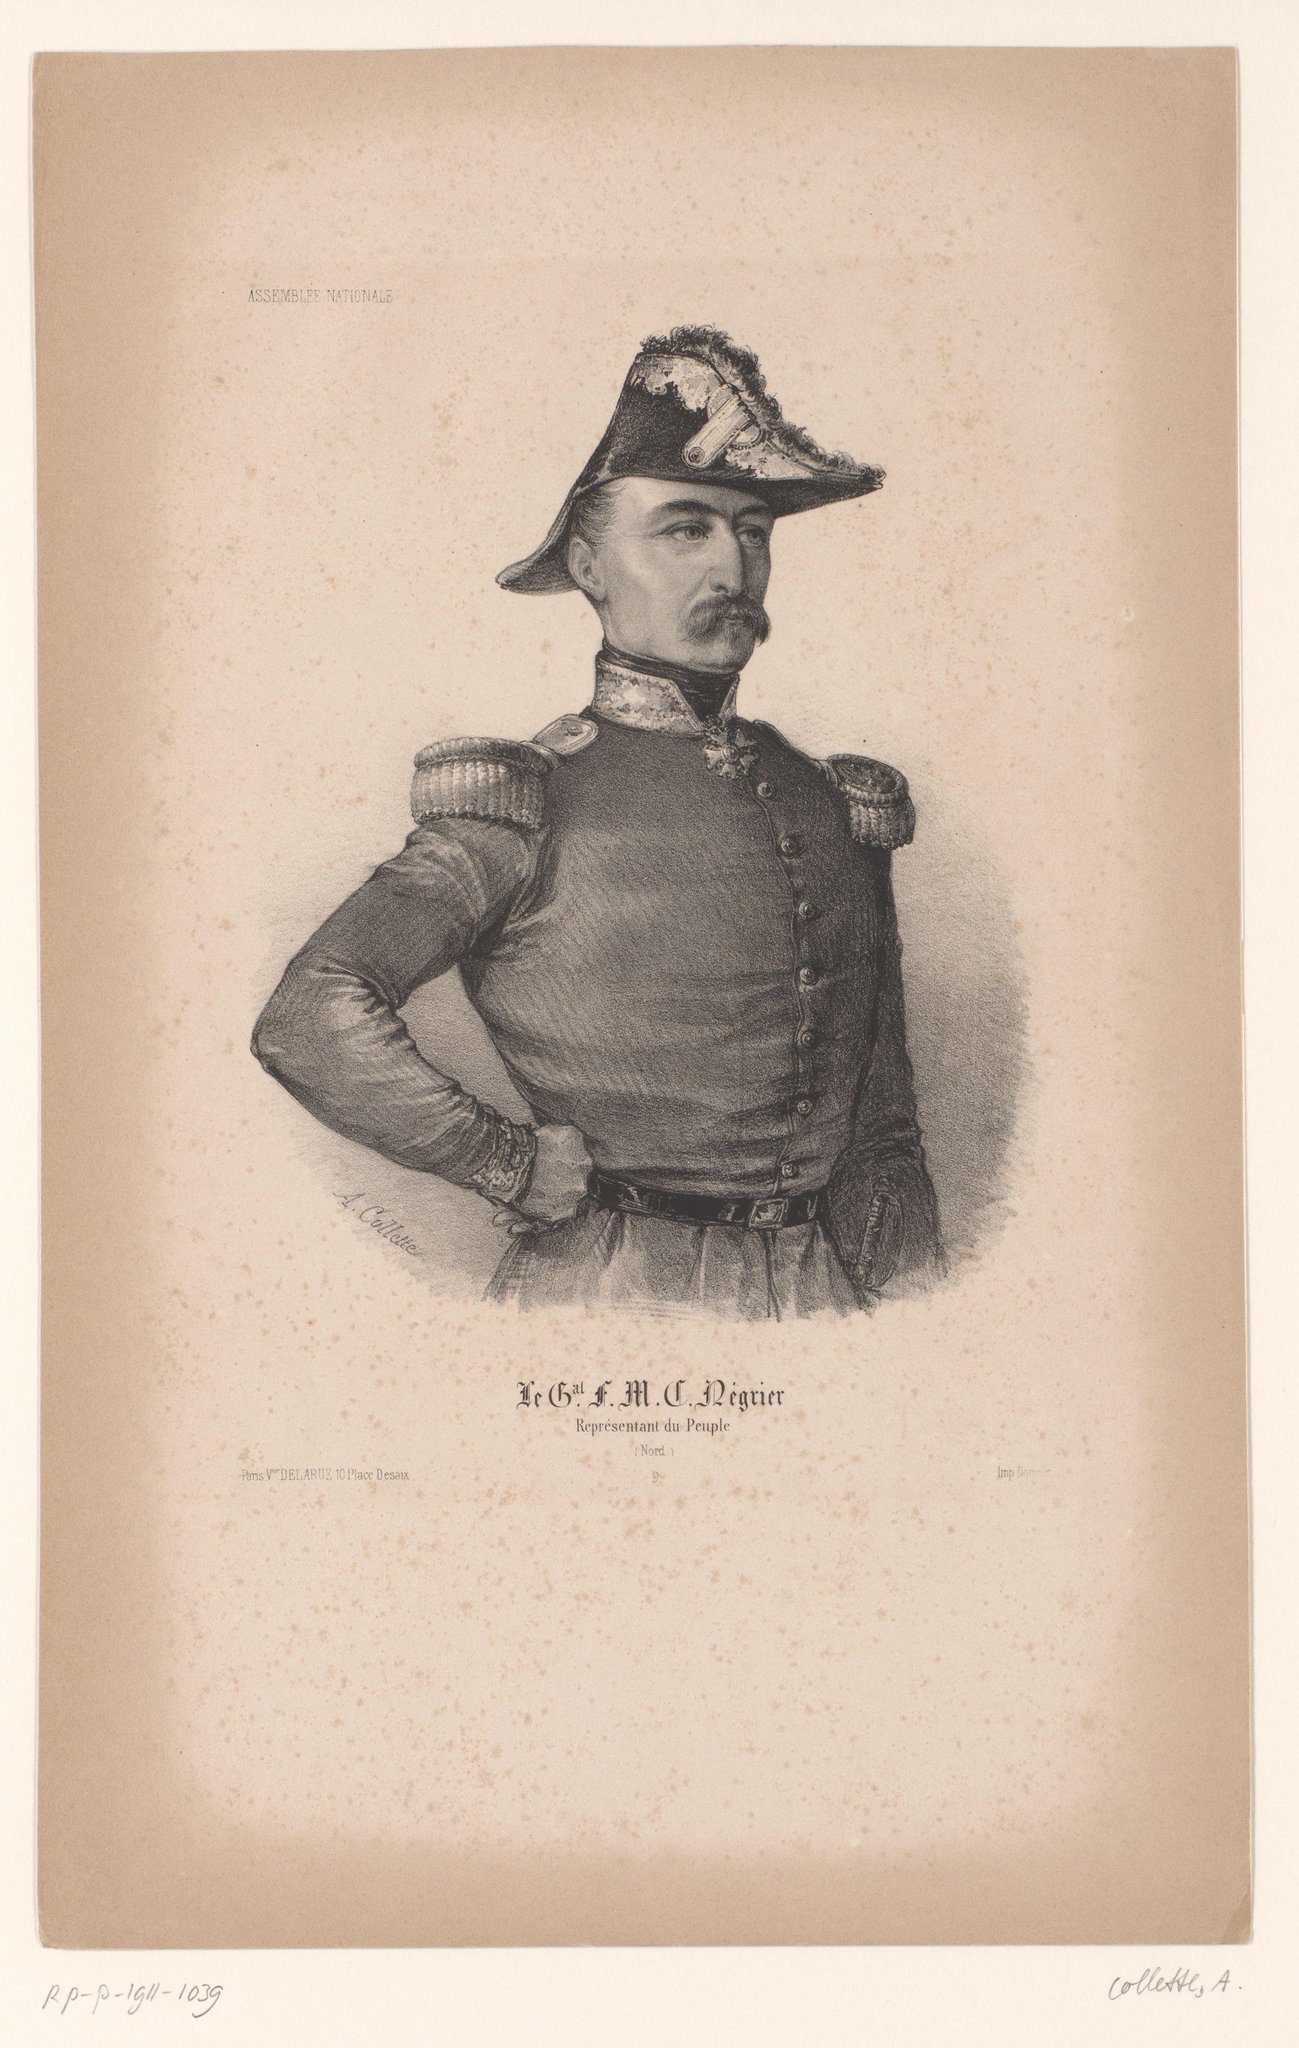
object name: print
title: Portret van generaal François-Marie-Casimir de Négrier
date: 1848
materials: paper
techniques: lithograph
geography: paris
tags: paris, politician, historical persons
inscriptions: collector's mark: Lugt 2228a